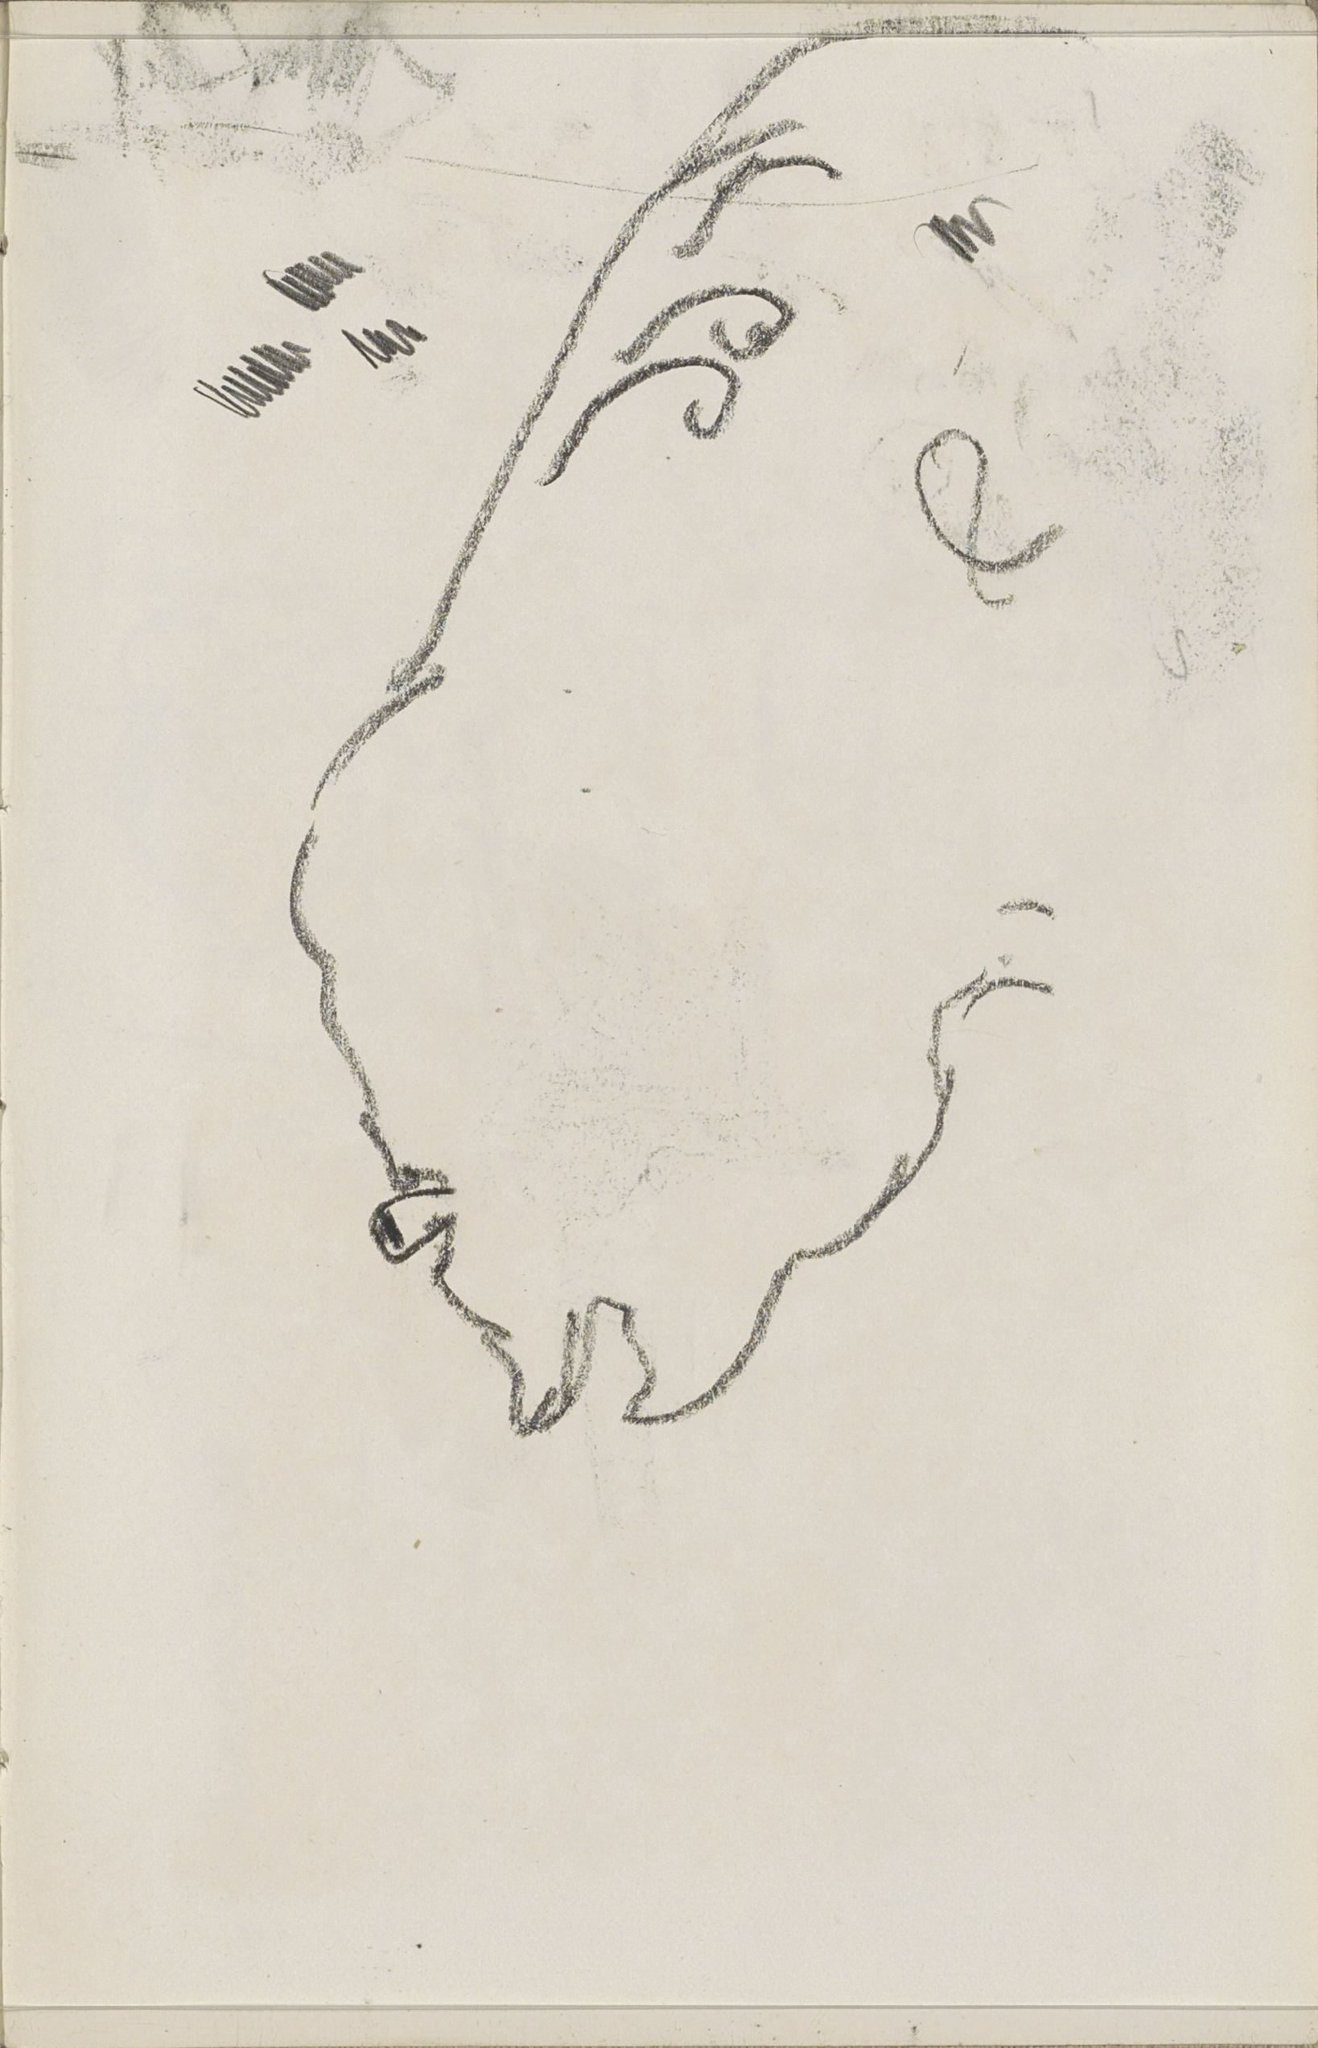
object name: sketchbook leaf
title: Fantasiefiguur met één oog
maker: cornelis vreedenburgh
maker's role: draughtsman, print maker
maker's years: 1880-1946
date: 1890-1946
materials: paper, pencil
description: Blad 41 recto uit een schetsboek met 41 bladen.